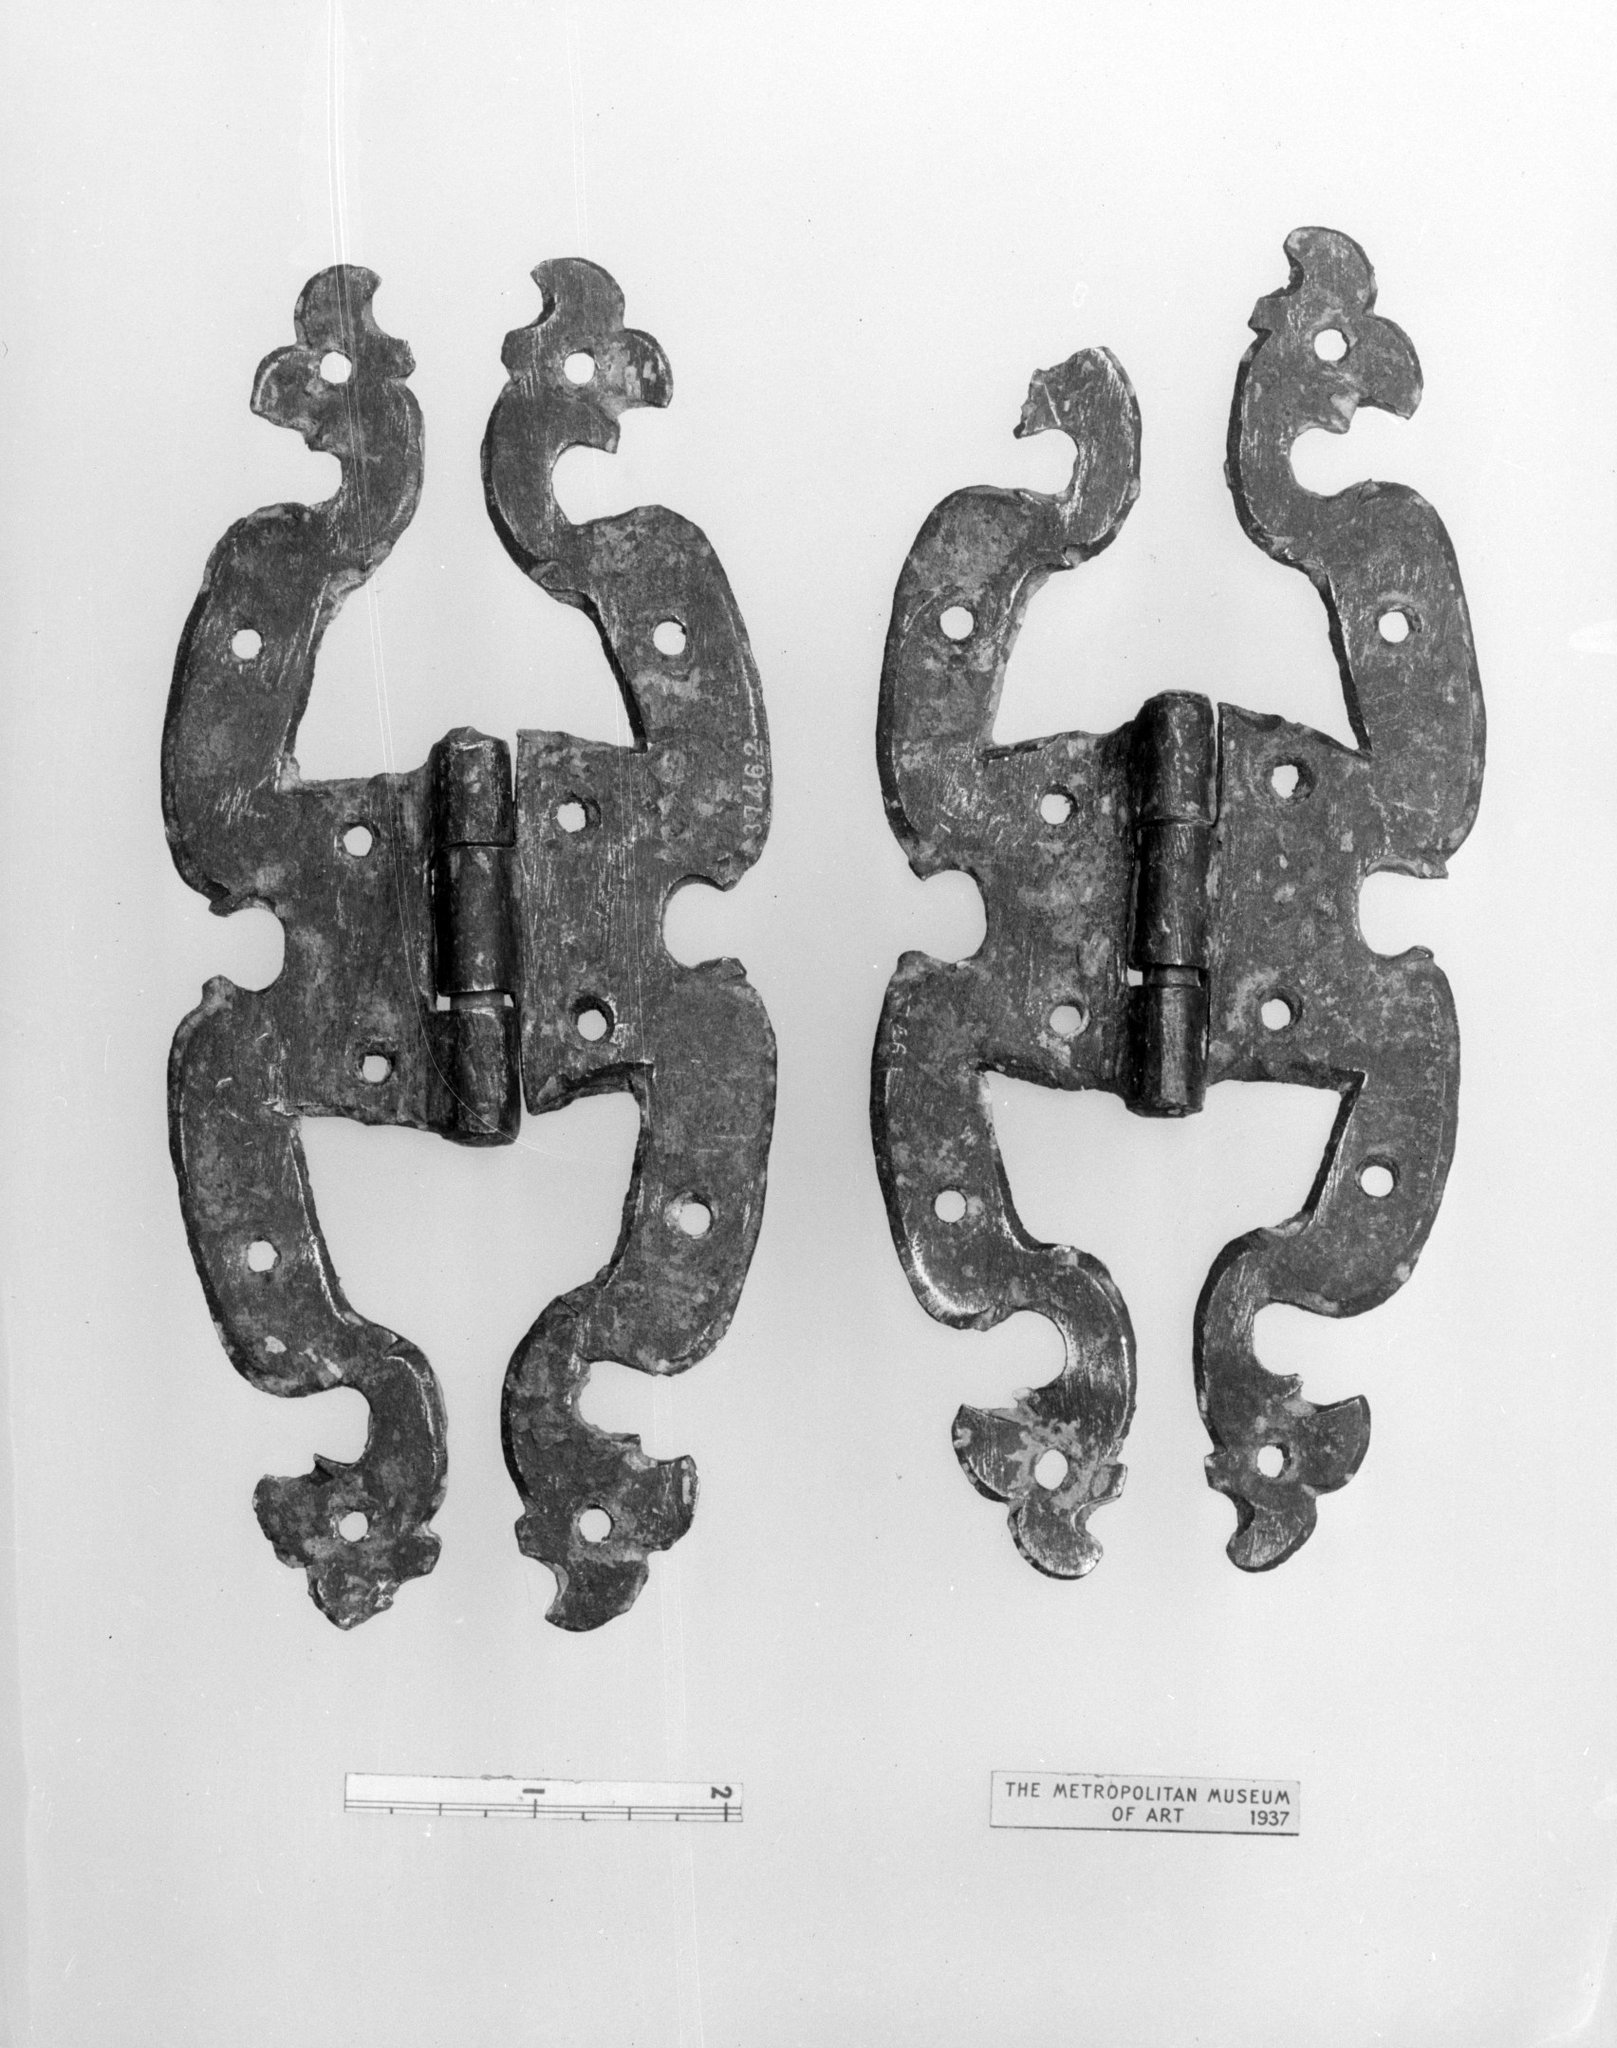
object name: hinge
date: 1630-1670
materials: iron